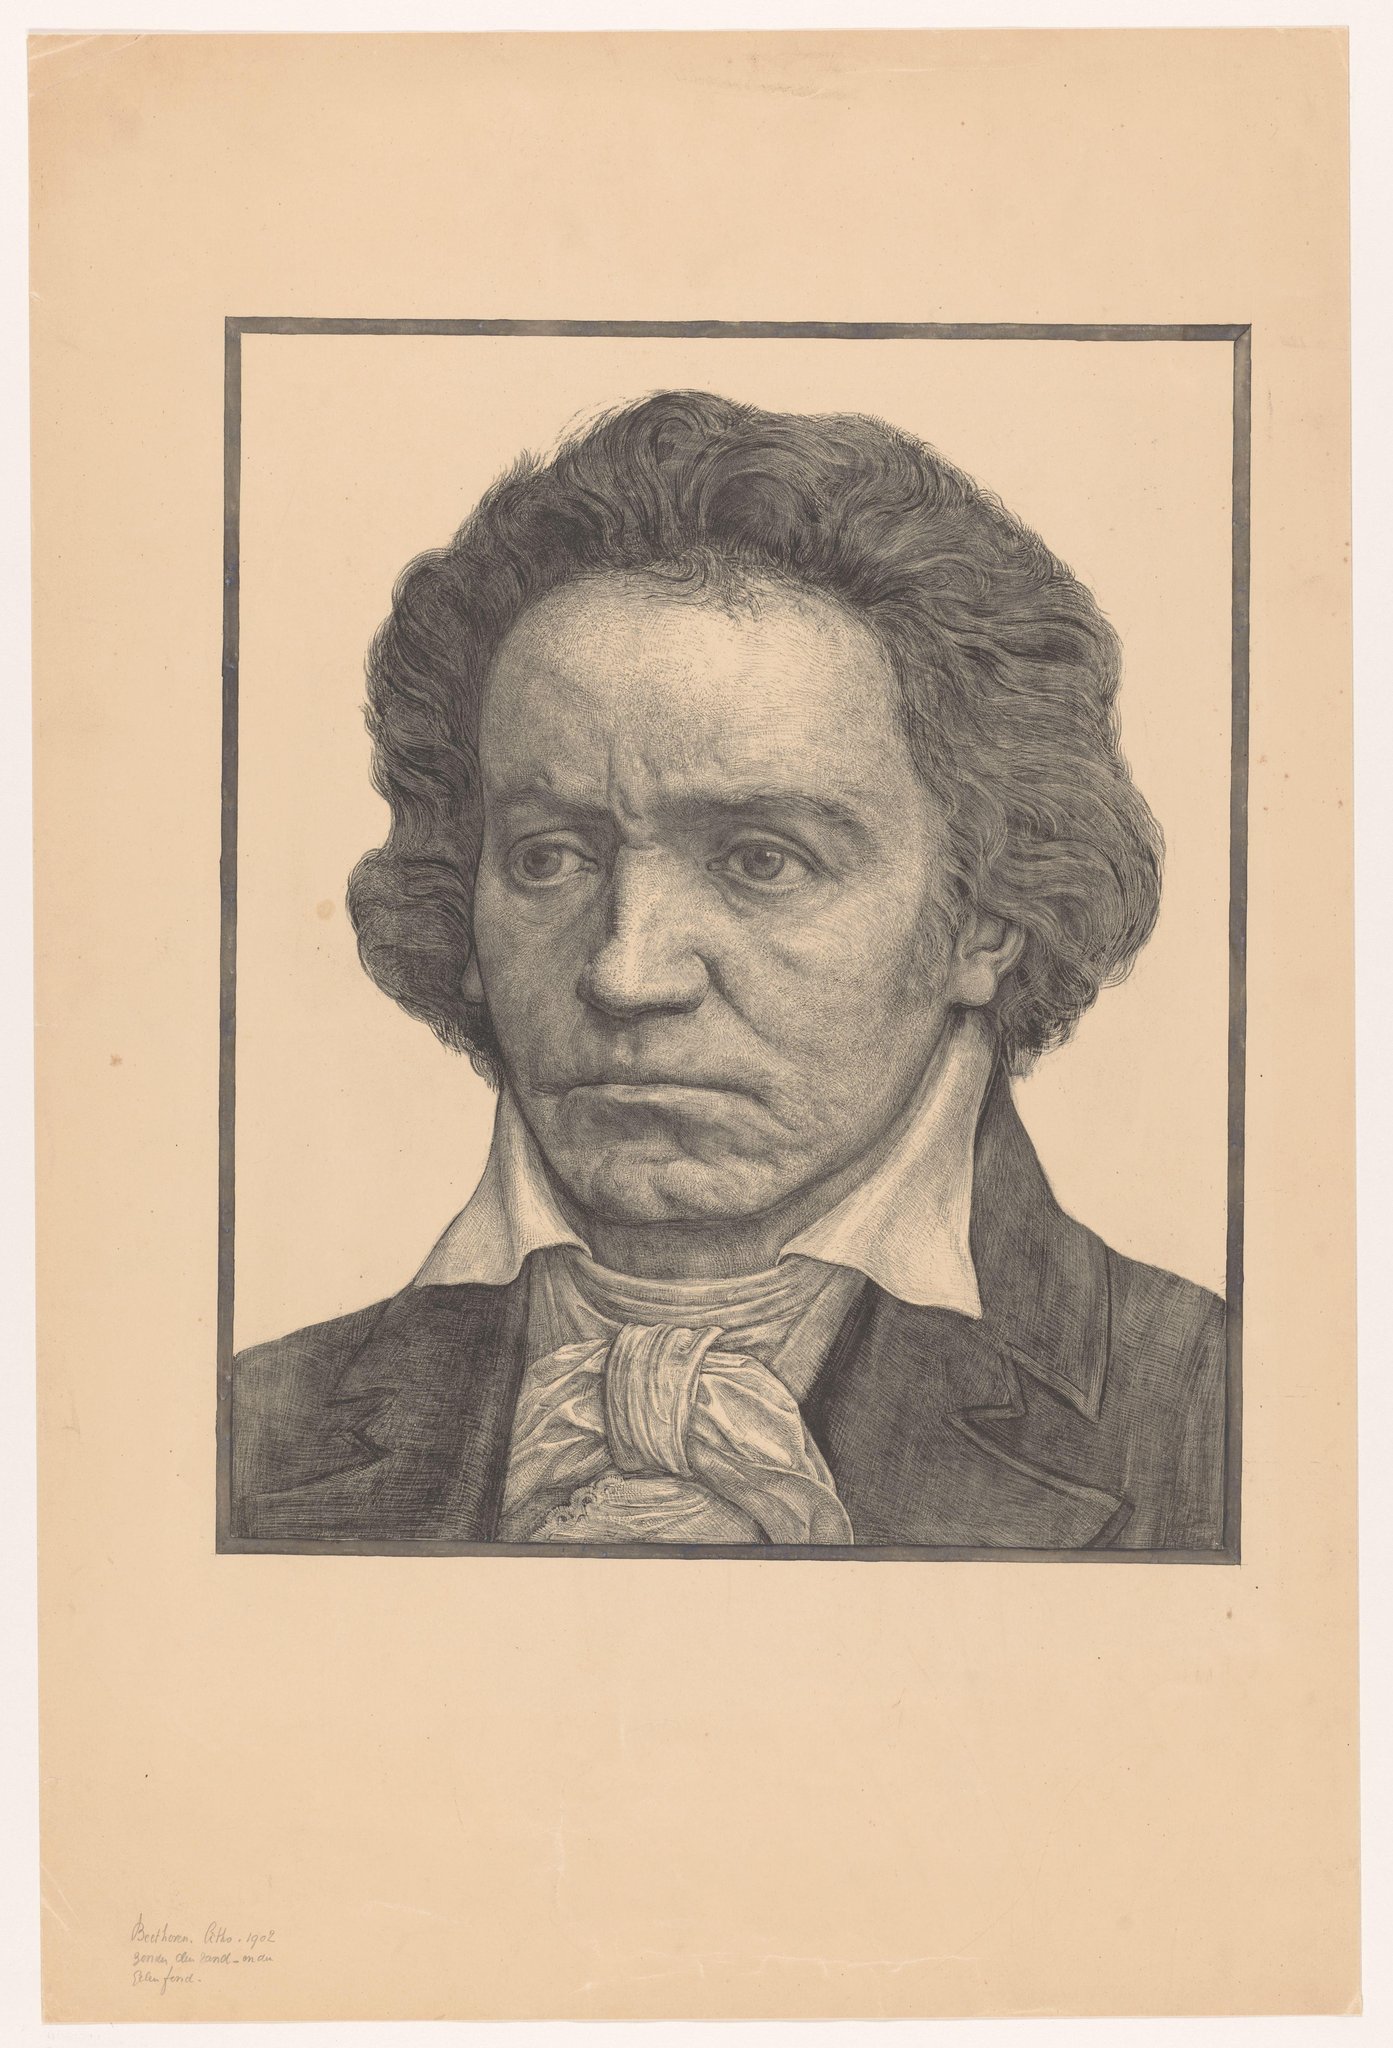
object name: print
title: Beethoven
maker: antoon derkinderen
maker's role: draughtsman, painter, print maker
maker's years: 1859-1925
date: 1902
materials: paper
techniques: lithograph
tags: vienna, portrait of composer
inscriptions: collector's mark: Lugt 2228, inscription: ‘zonder den rand onder gelen fond.’